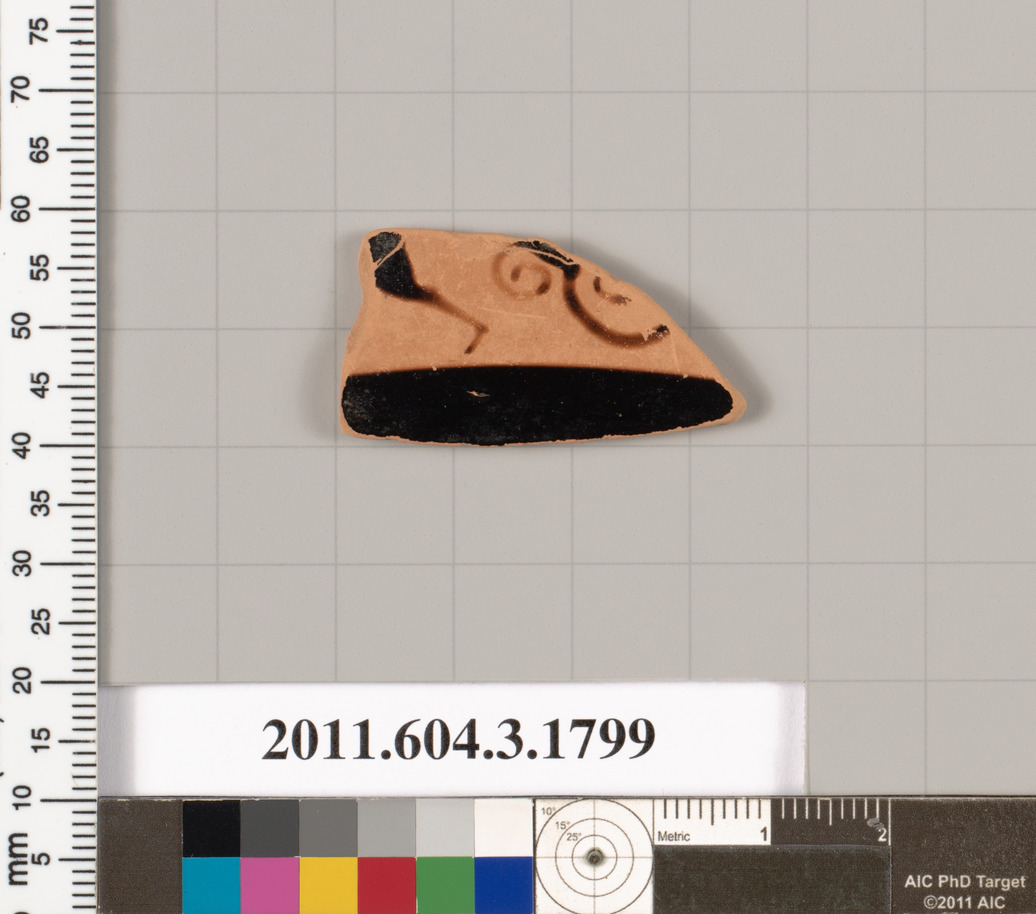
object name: kylix fragment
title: Terracotta fragment of a kylix: Lip cup (drinking cup)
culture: greek, attic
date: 550-526 BCE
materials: terracotta